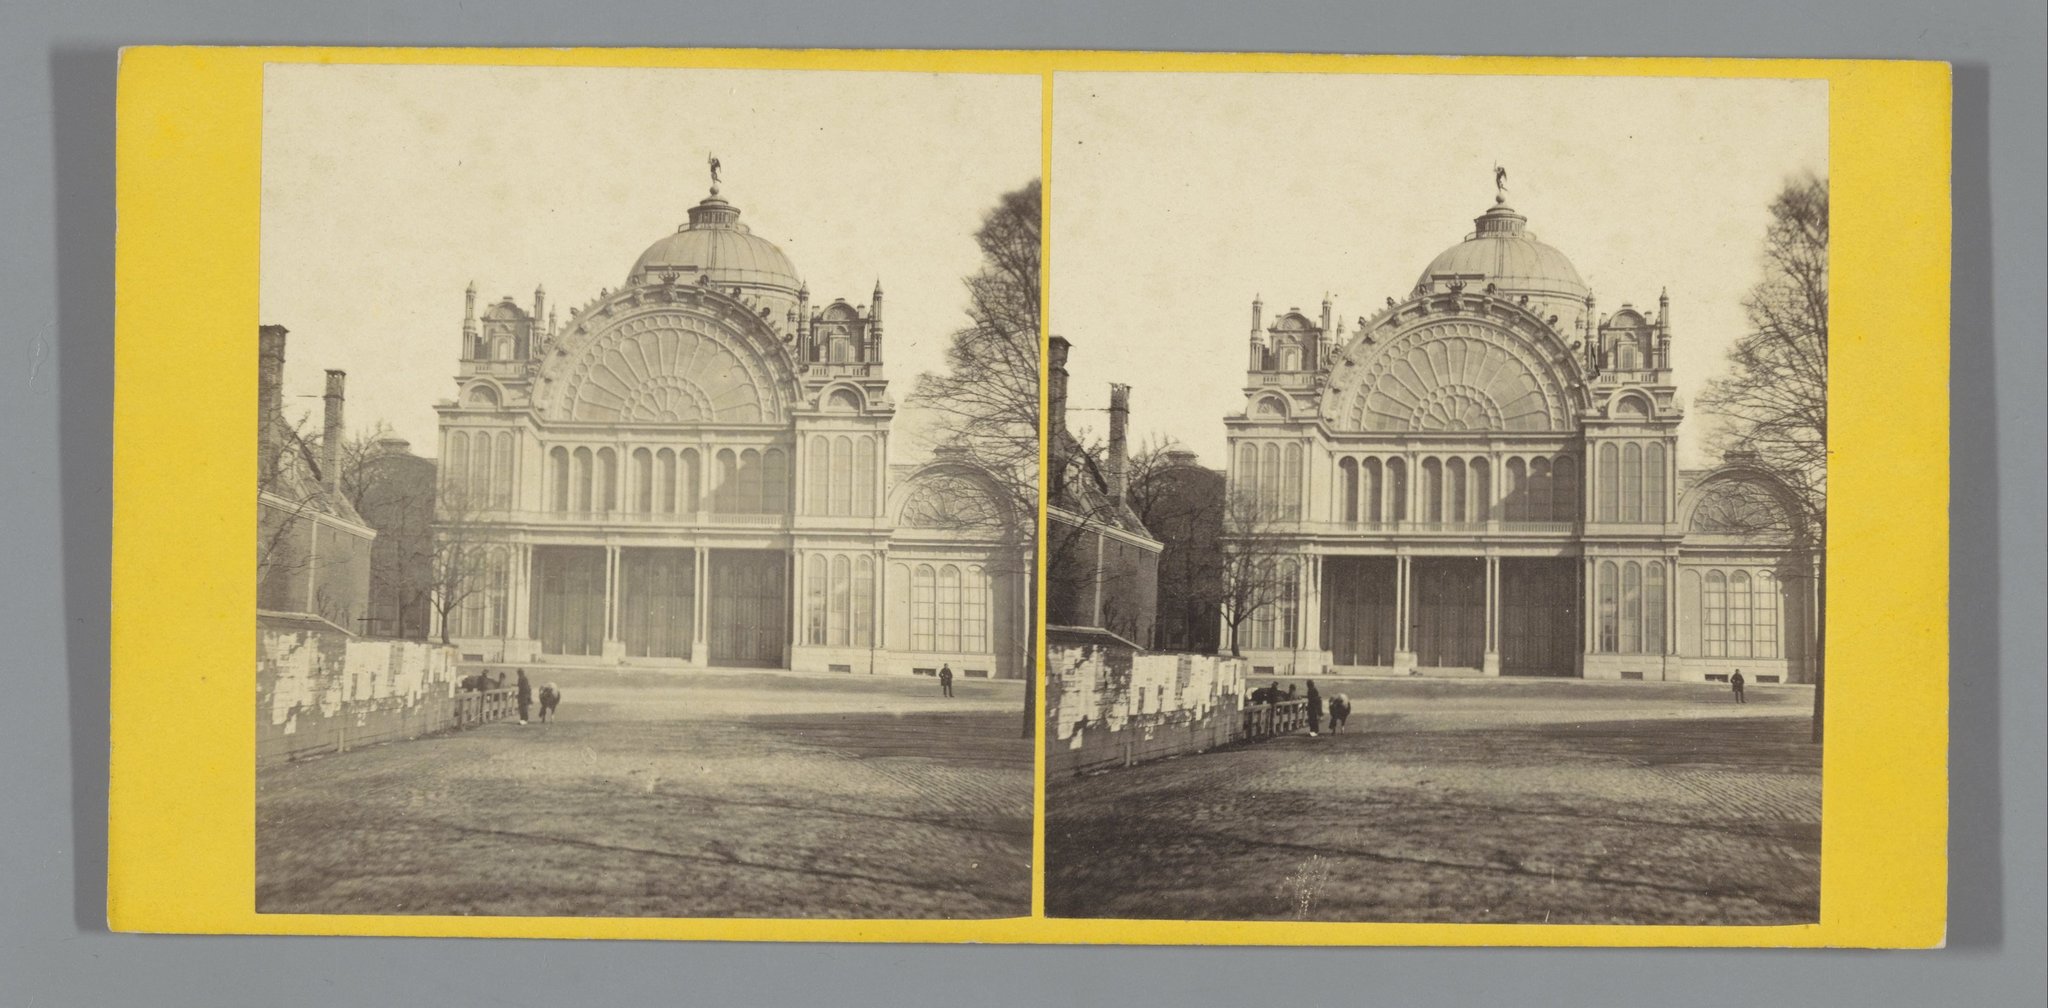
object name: stereograph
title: Gezicht op het Paleis voor Volksvlijt in Amsterdam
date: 1860-1885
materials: cardboard, photographic support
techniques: albumen print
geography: amsterdam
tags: palace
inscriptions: inscription: ‘Uitgegeven bij A. JAGER, Water 110, te Amsterdam.’, annotation: ‘Amsterdam./ Het Paleis voor Volksvlijt.’, number: ‘23’